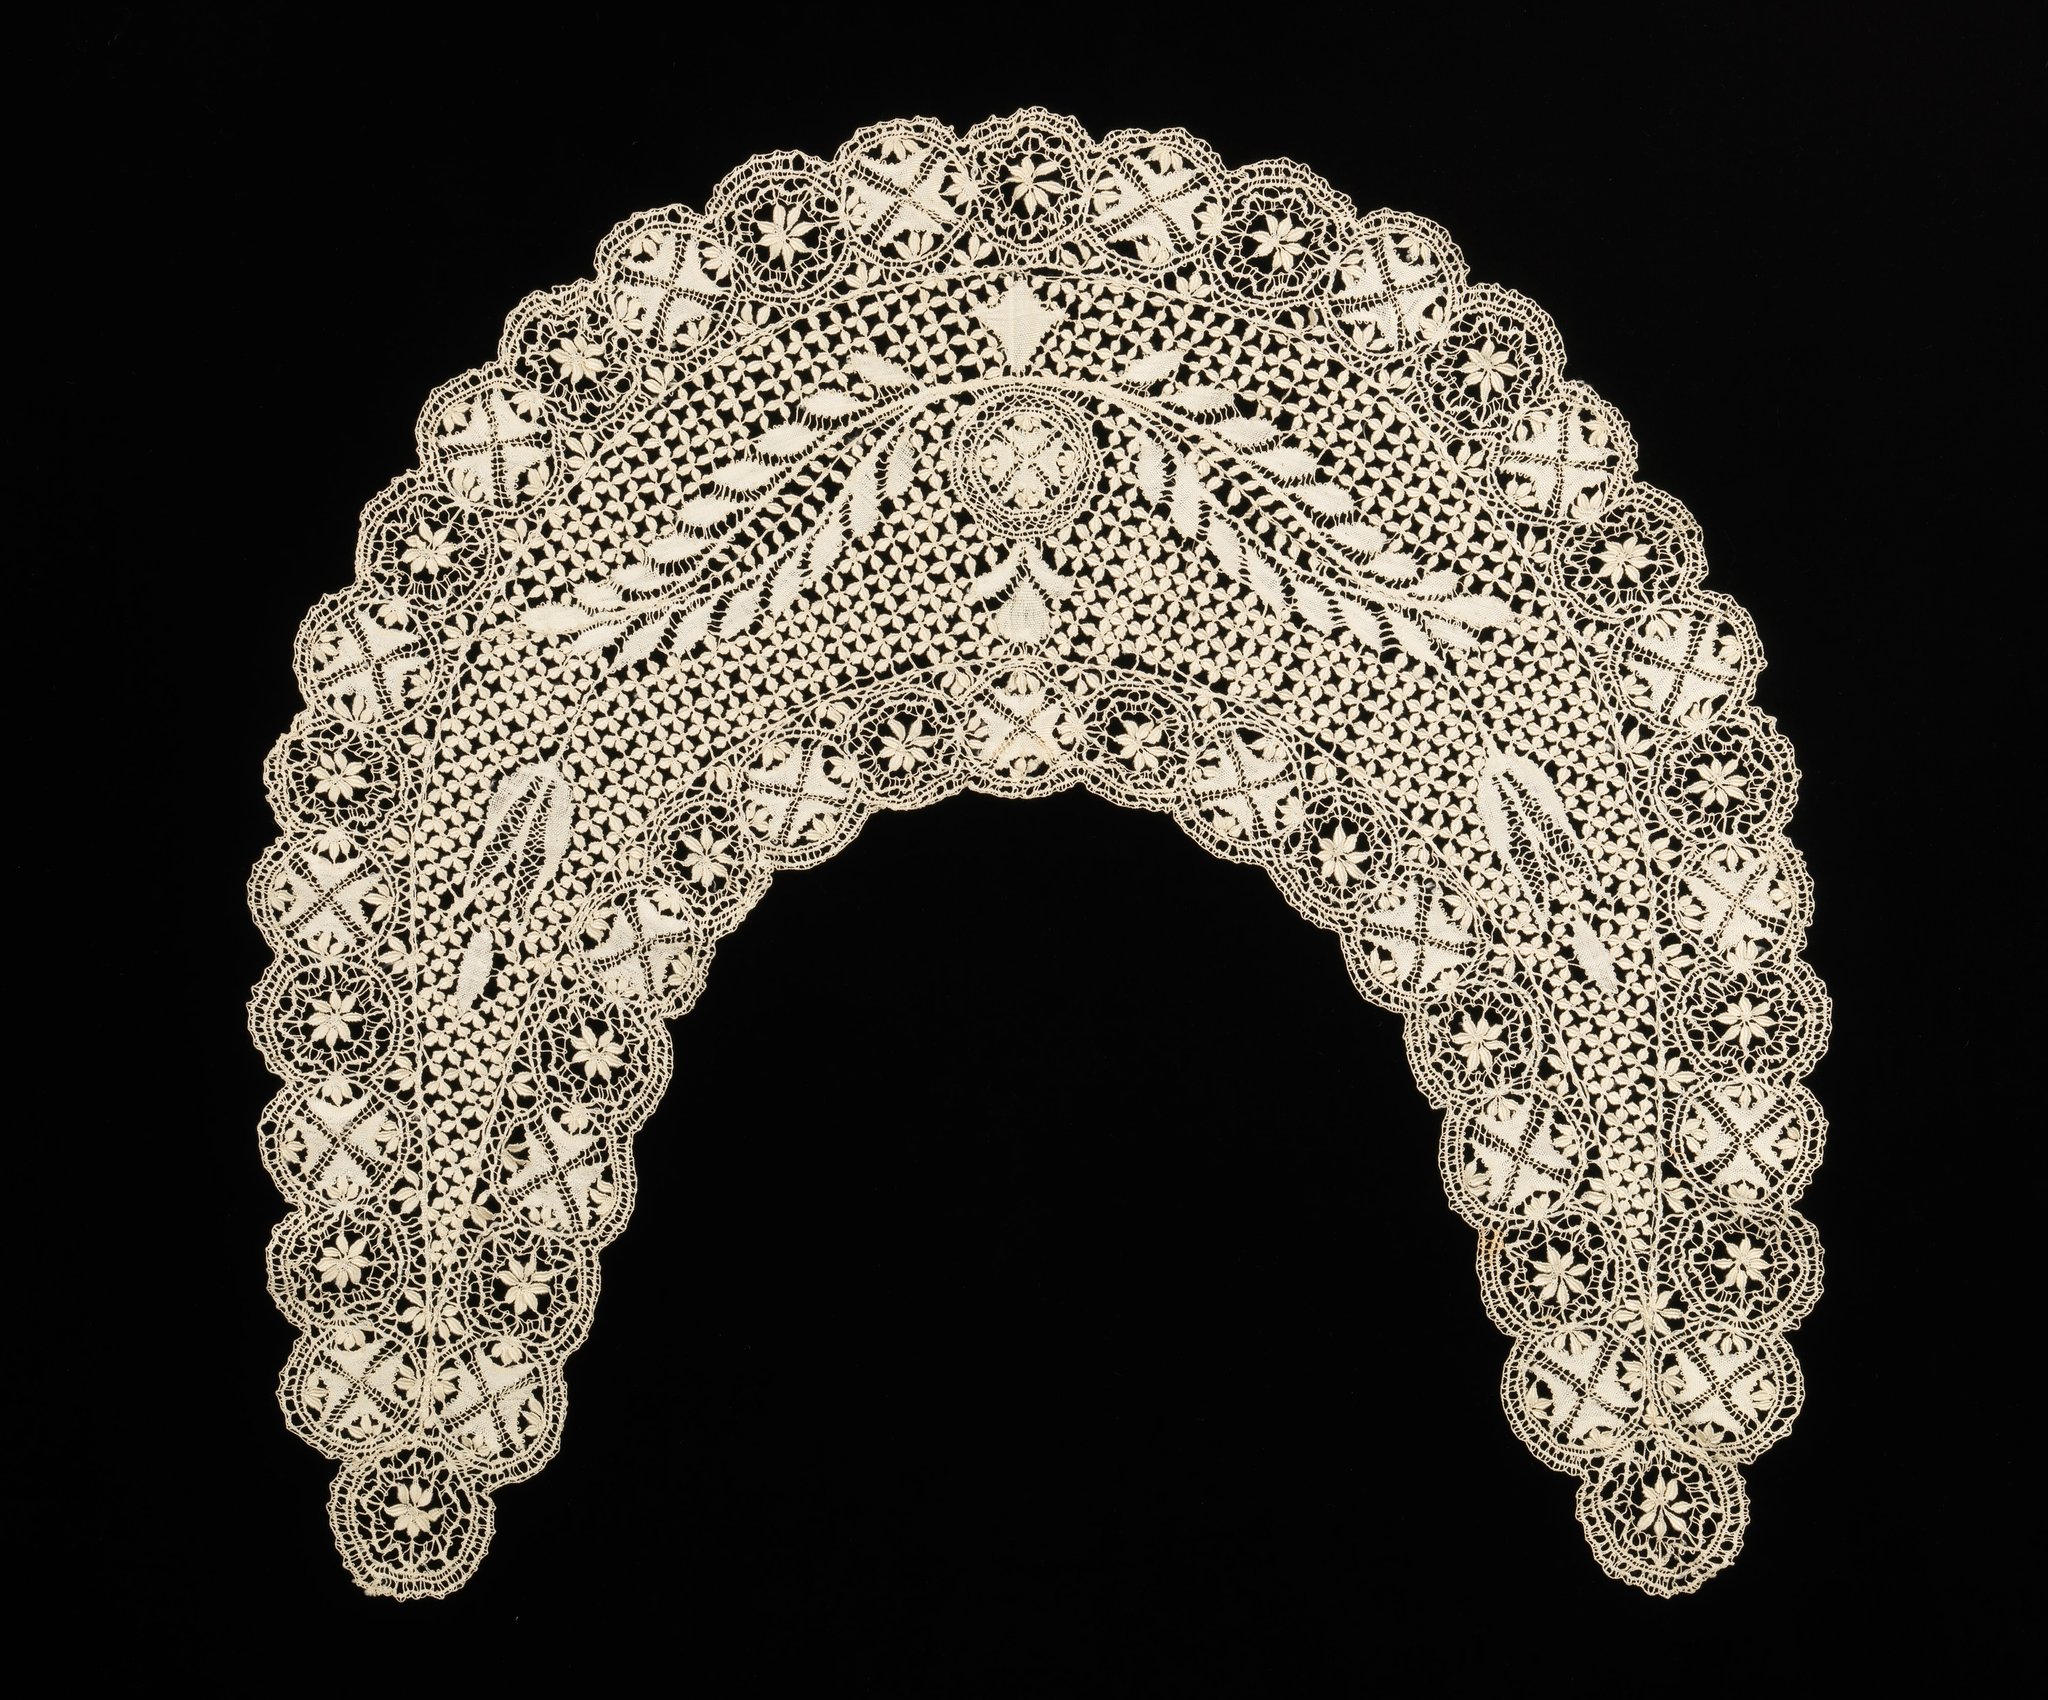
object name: collar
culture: maltese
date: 1851-1875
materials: silk